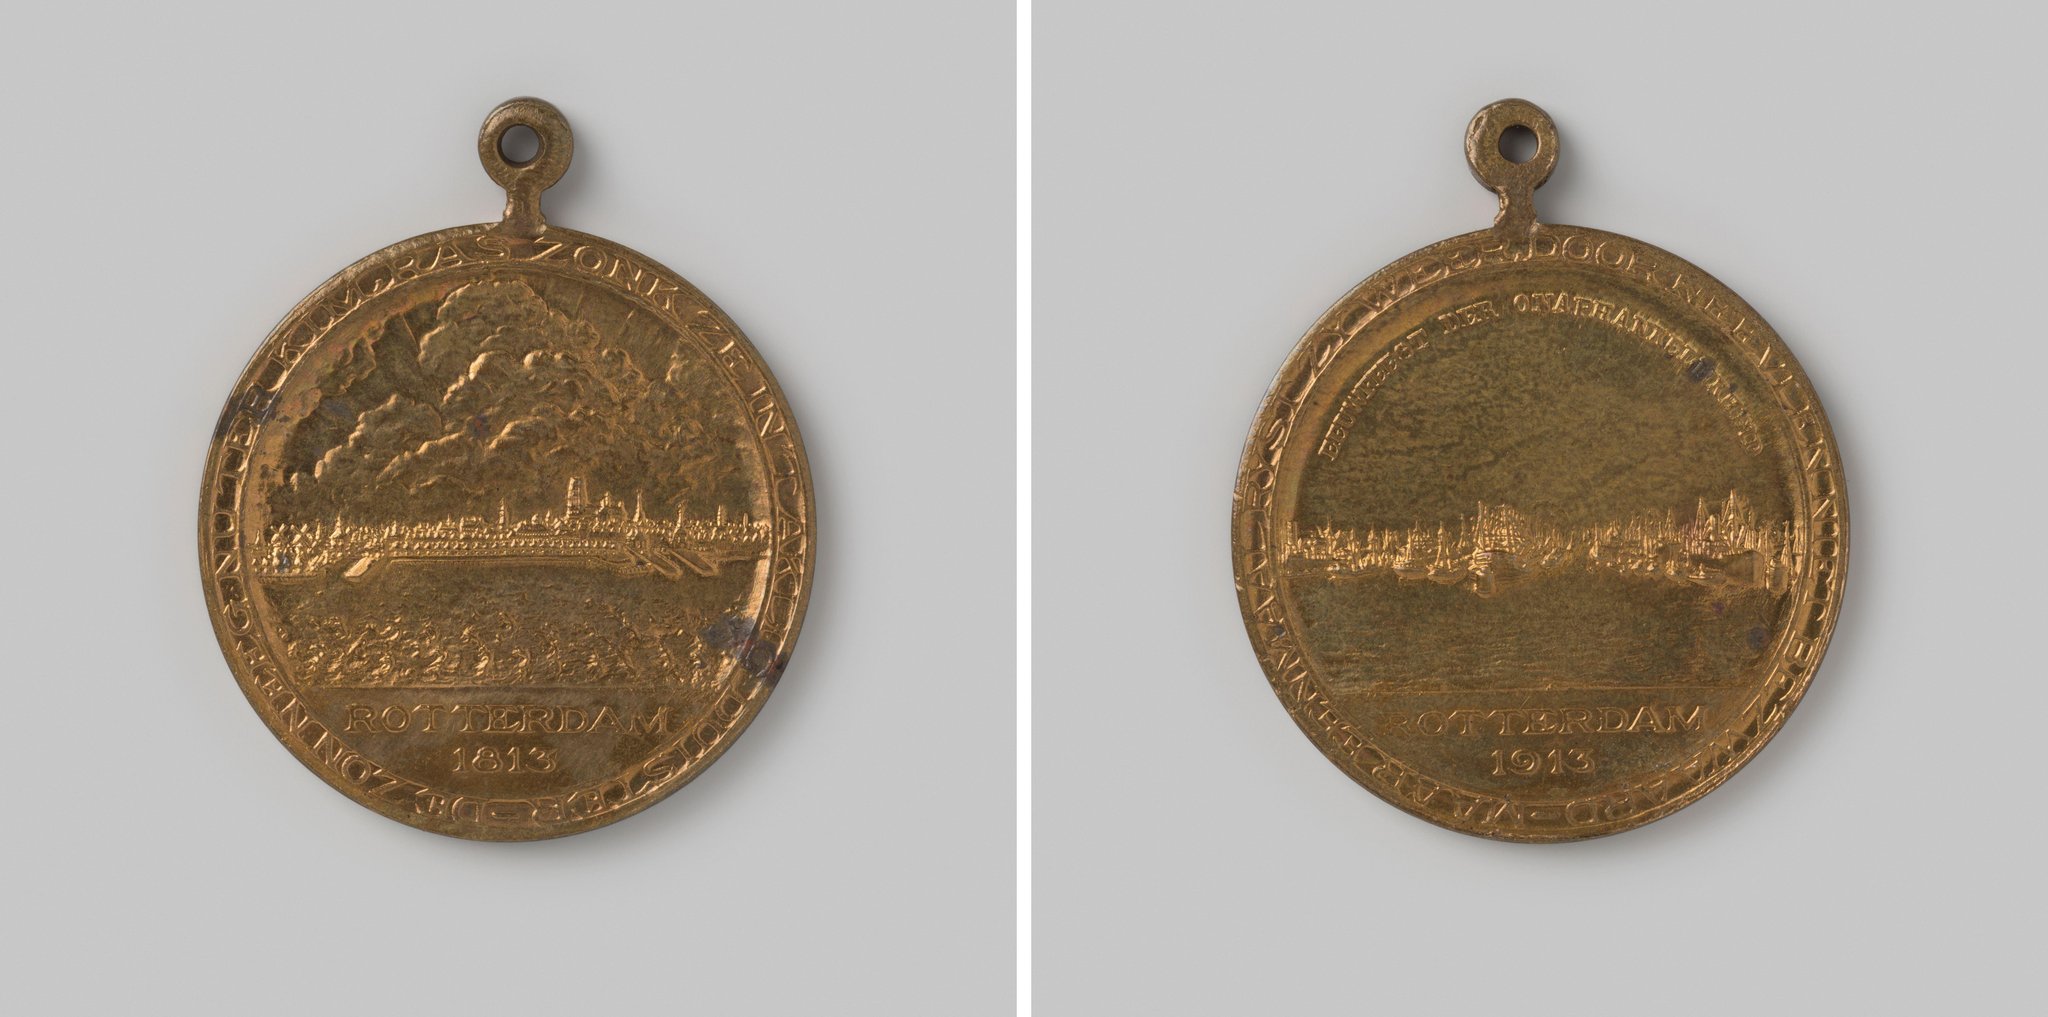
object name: medal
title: Honderd jaar onafhankelijkheid te Rotterdam 1913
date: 1913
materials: brass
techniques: striking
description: Vergulde penning met draagoog, op de voorzijde het aanzicht van Rotterdam in 1813, met onder- en omschrift, op de keerzijde het aanzicht in 1913, met onder- en dubbel omschrift.